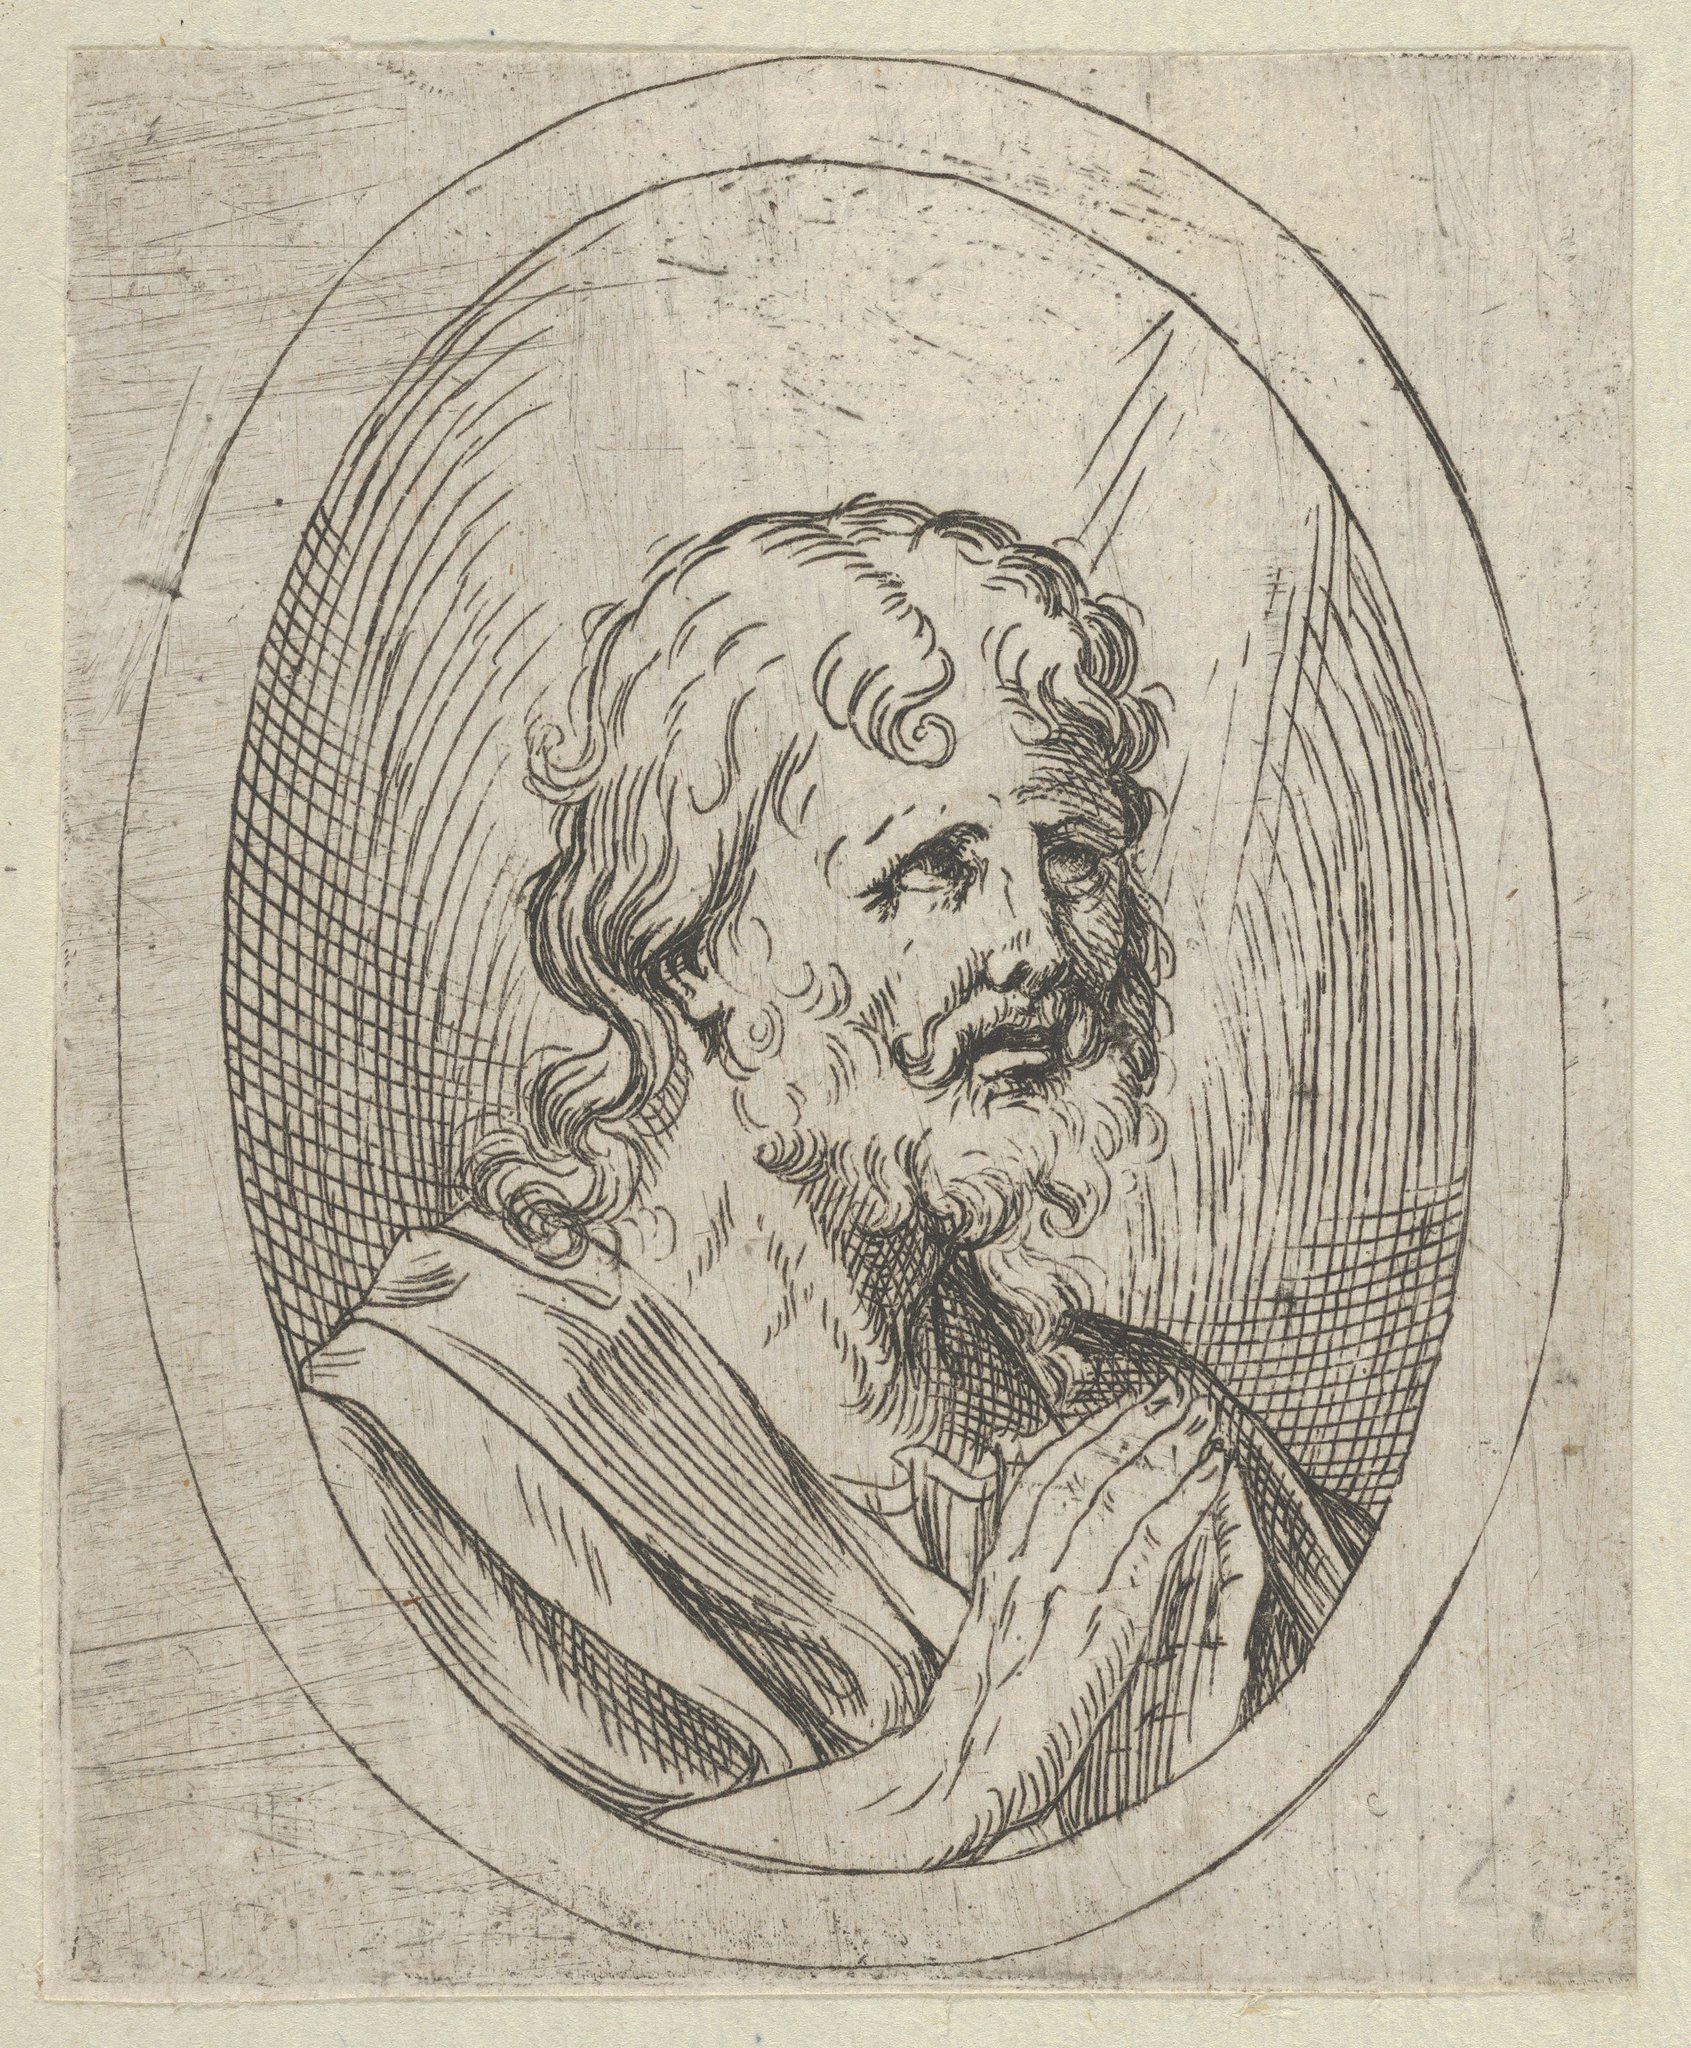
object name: print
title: An apostle raising his eyes in prayer, in an oval frame, from "Christ, the Virgin, and Thirteen Apostles"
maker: anonymous, 17th century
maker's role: artist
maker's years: 1600-1700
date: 1600-1640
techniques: etching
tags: portraits,apostles,praying